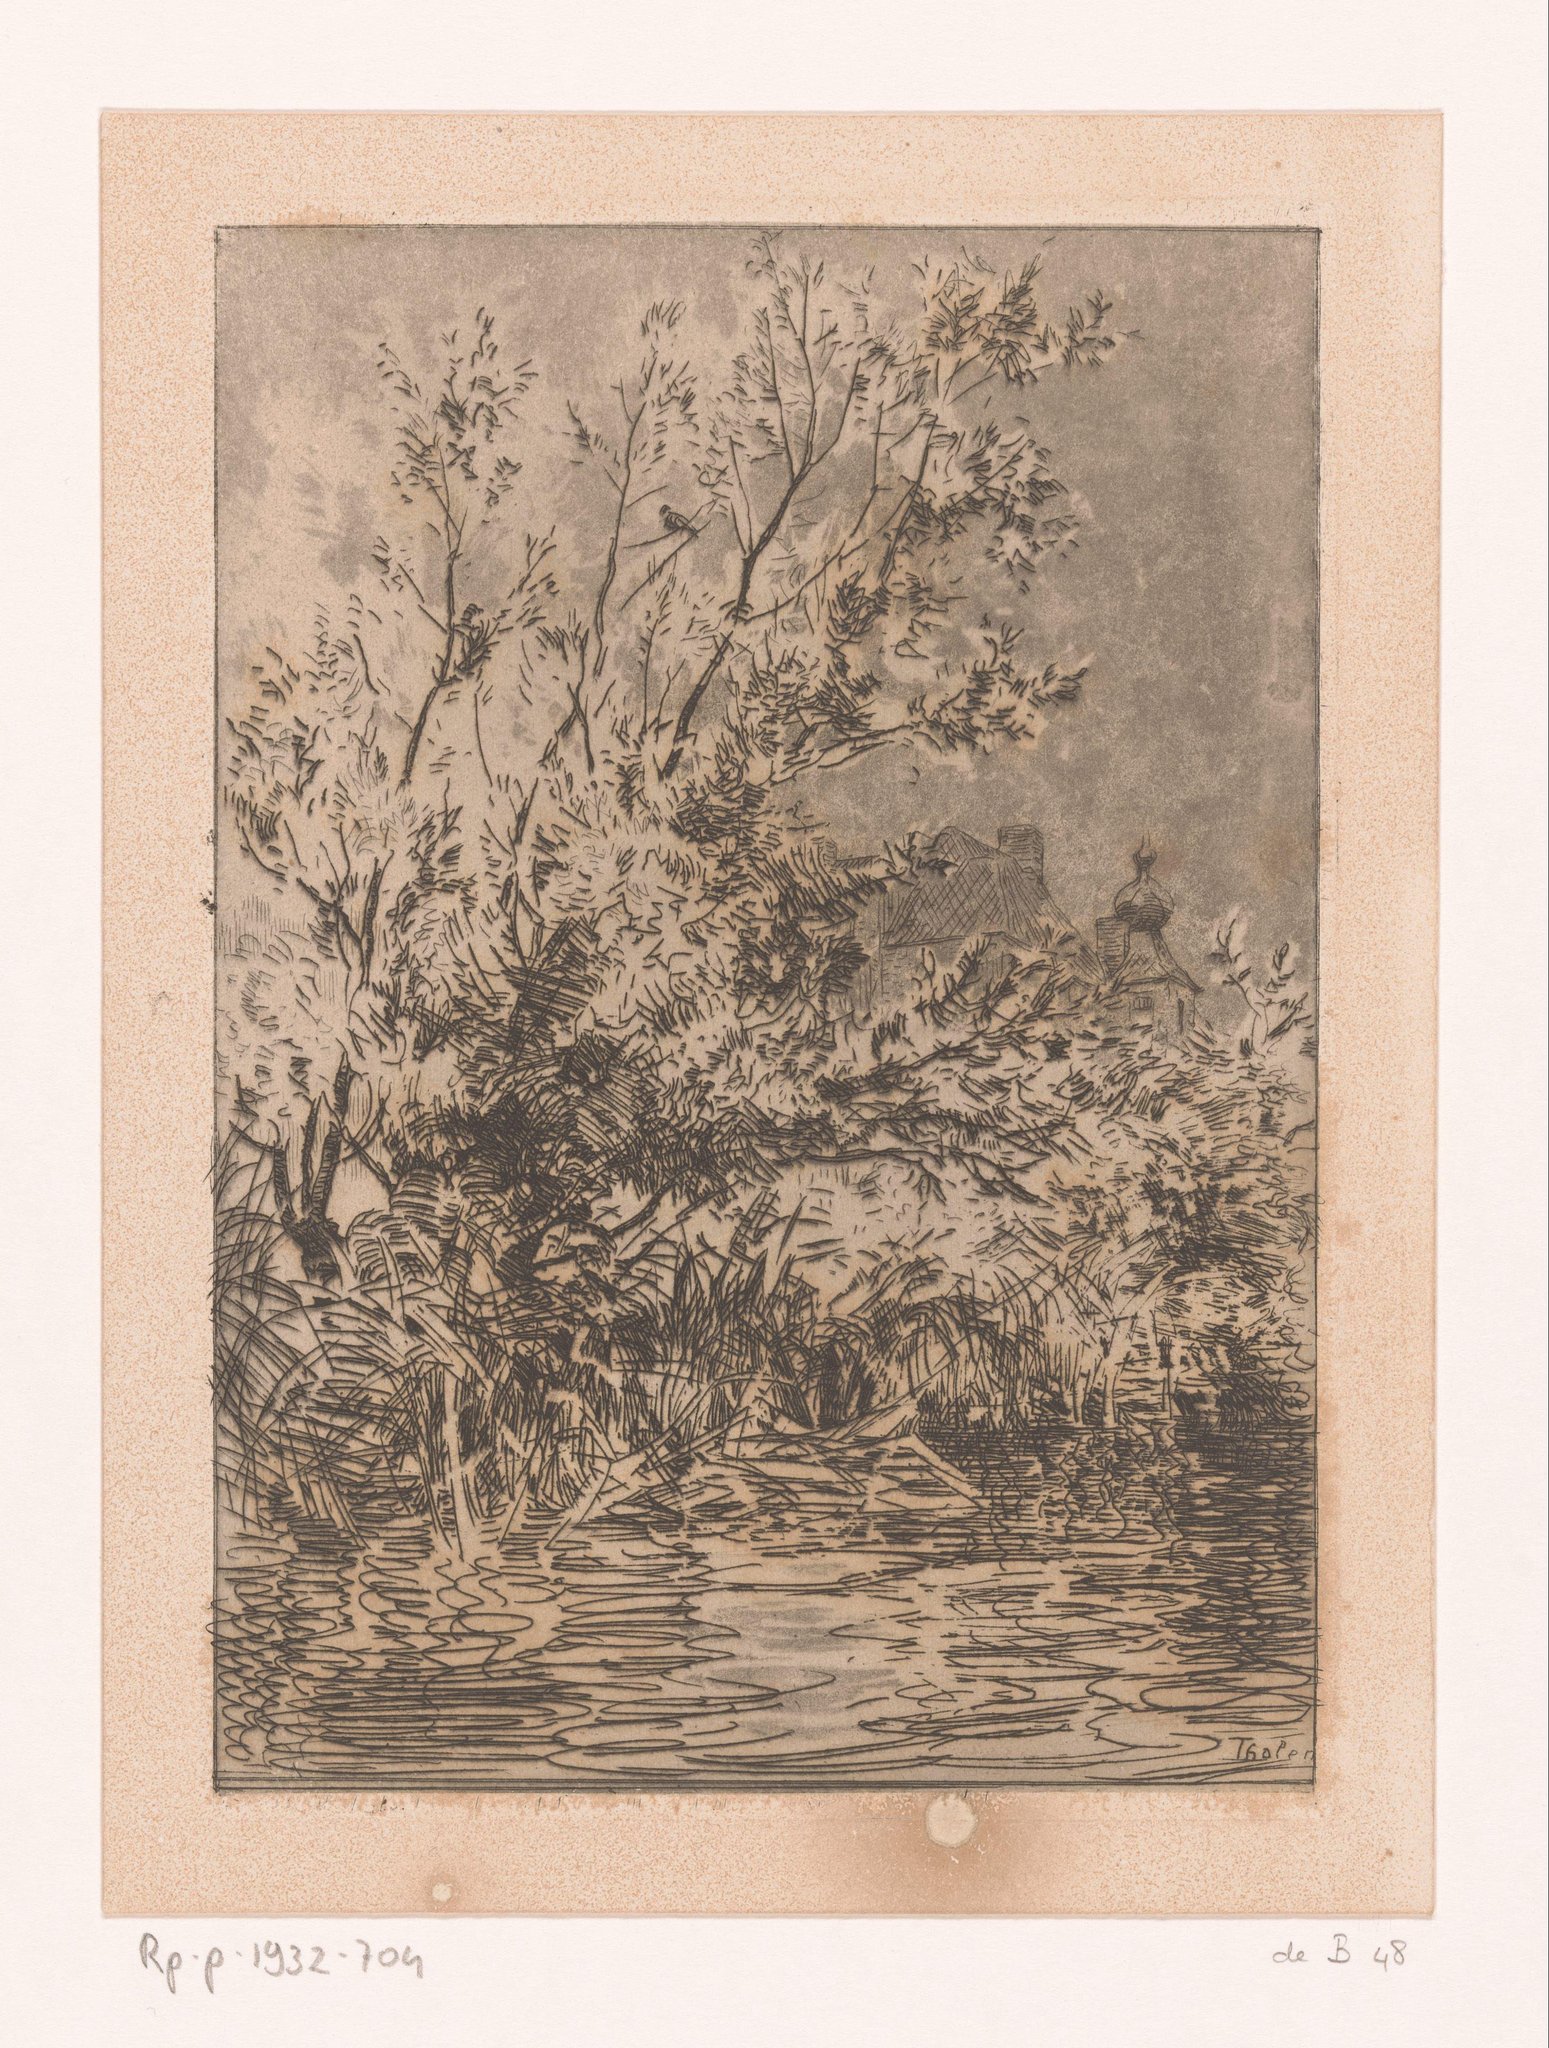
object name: print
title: Wilgen en kasteel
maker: willem bastiaan tholen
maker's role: draughtsman, painter, print maker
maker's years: 1860-1931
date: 1870-1931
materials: paper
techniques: aquatint, etching, intaglio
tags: castle, trees: willow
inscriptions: collector's mark: Lugt 2228